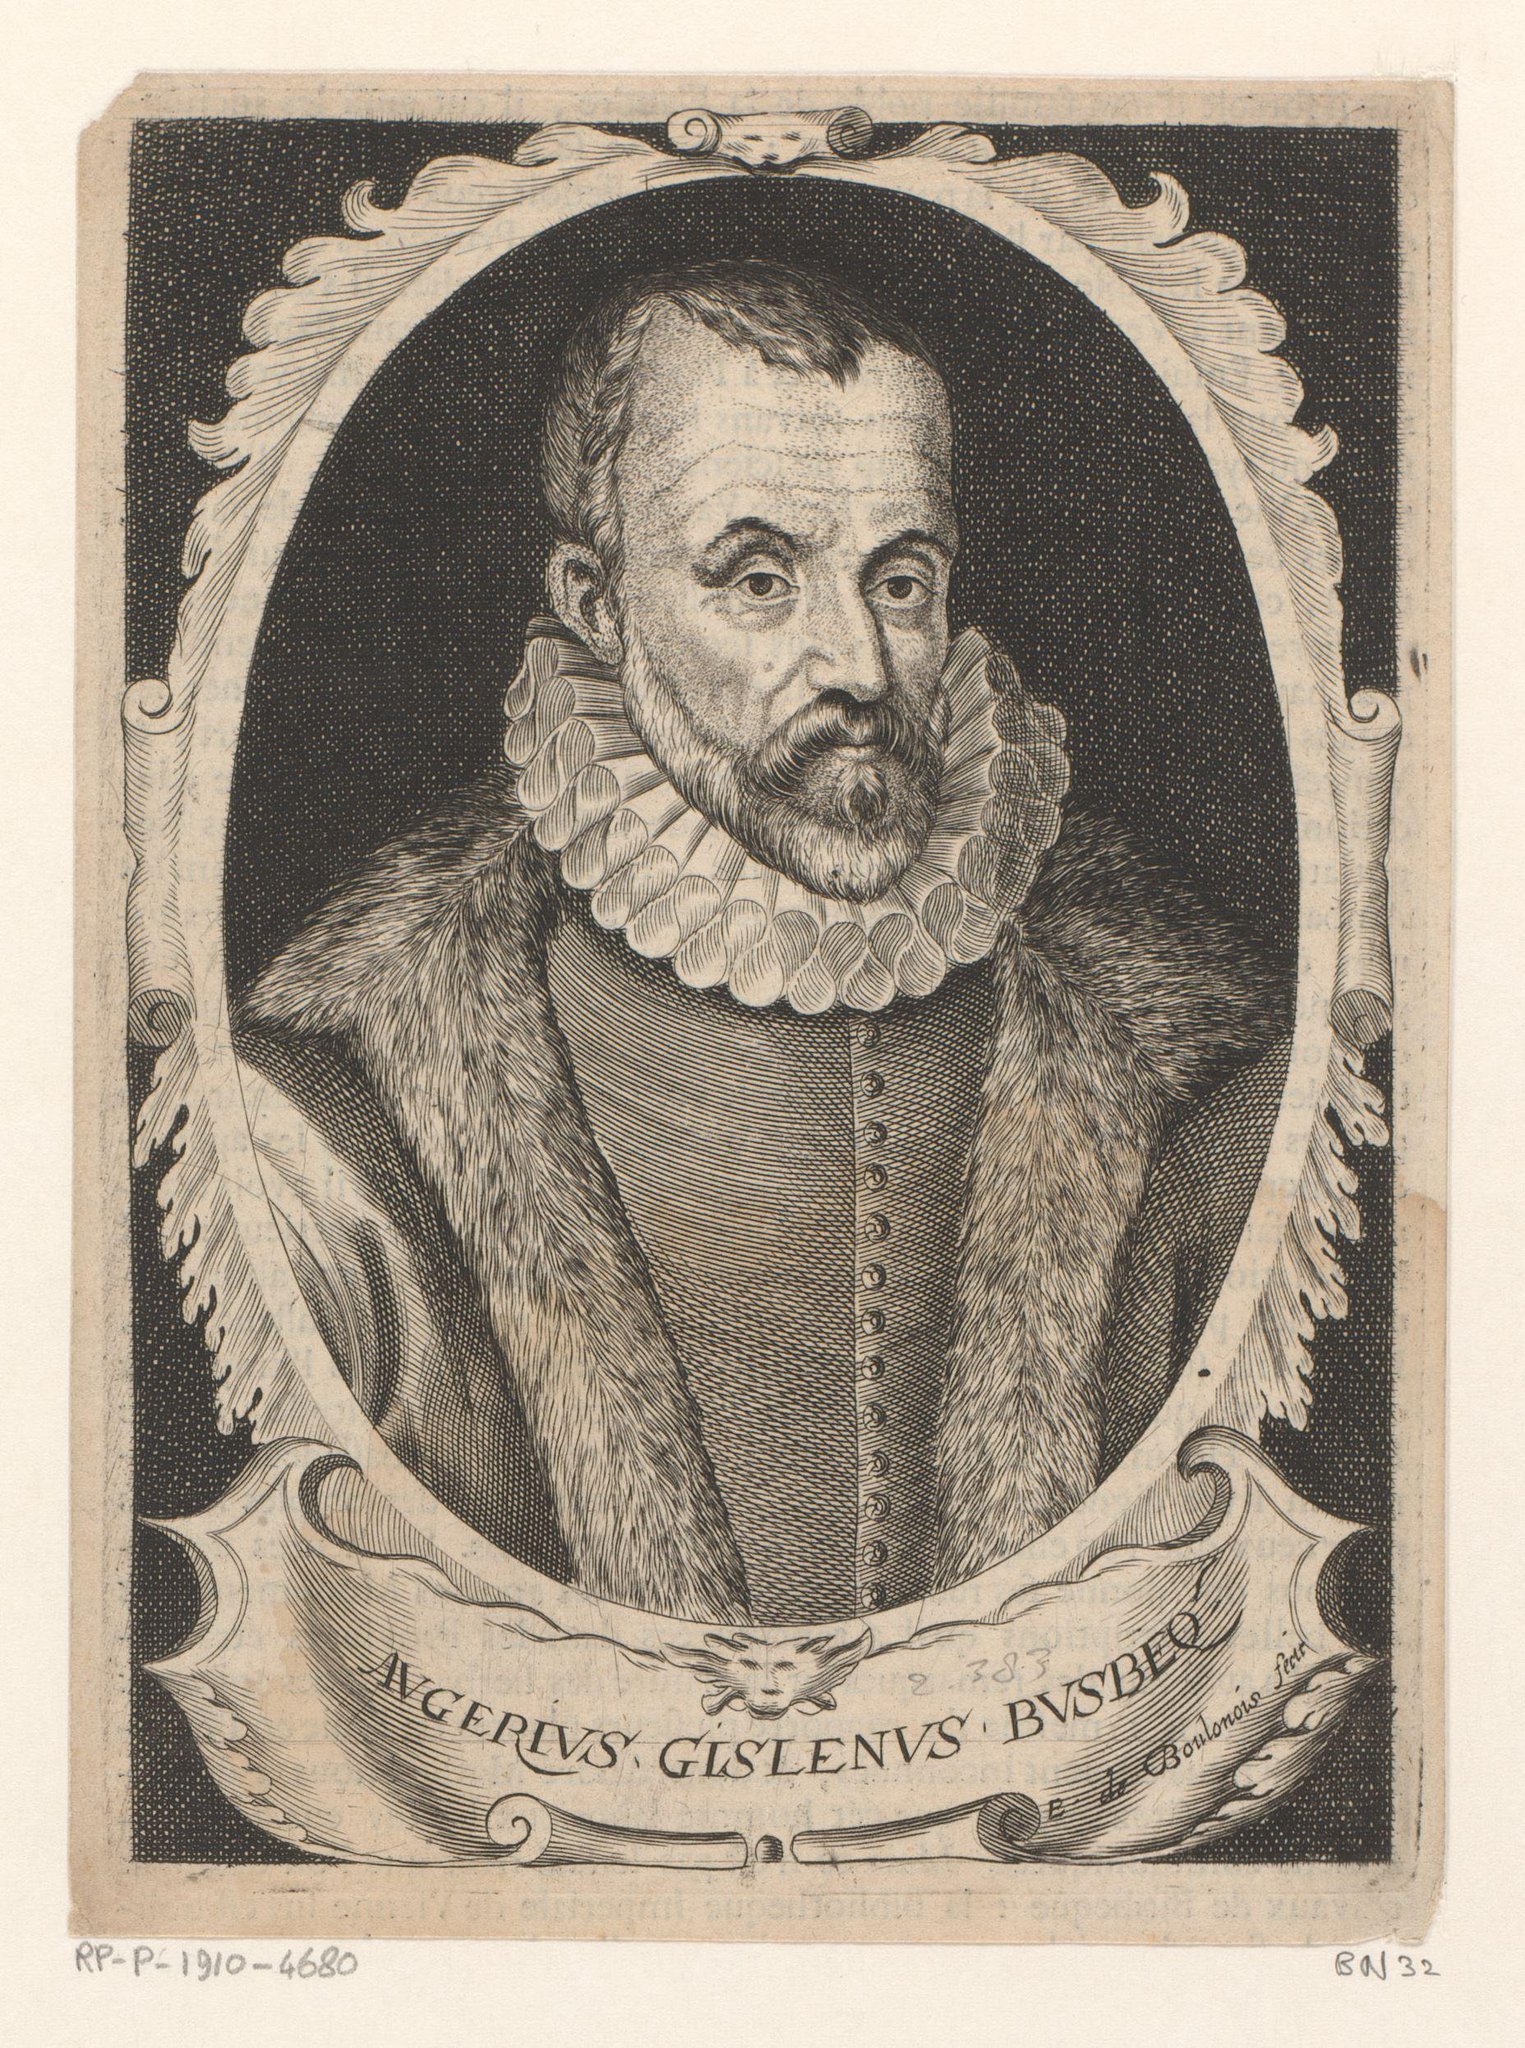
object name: book illustration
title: Portret van Ogier Ghislain de Busbecq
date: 1682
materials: paper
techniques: engraving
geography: brussels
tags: scholar, philosopher, historical persons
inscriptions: collector's mark: Lugt 2228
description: Prent uit: Bullert, Isaac. Académie des Sciences et Arts contenant les vies et éloges his. des hommes illustres qui ont excellé en ces professions depuis environ quatre siècles. Brussel: Foppens, François, 1682. Het boek werd in 1682 eveneens in Amsterdam uitgegeven door de erfgenamen van Daniel Elzevier. Deze portretten dienen ter illustratie van de biografie van een kunstenaar of geleerde. De meeste portretten werden door Nicolas de Larmessin vervaardigd (162), 93 door De Boulonois en een derde door ongeïdentificeerde prentmakers. Dit betreft een illustratie op p. 79, deel I.